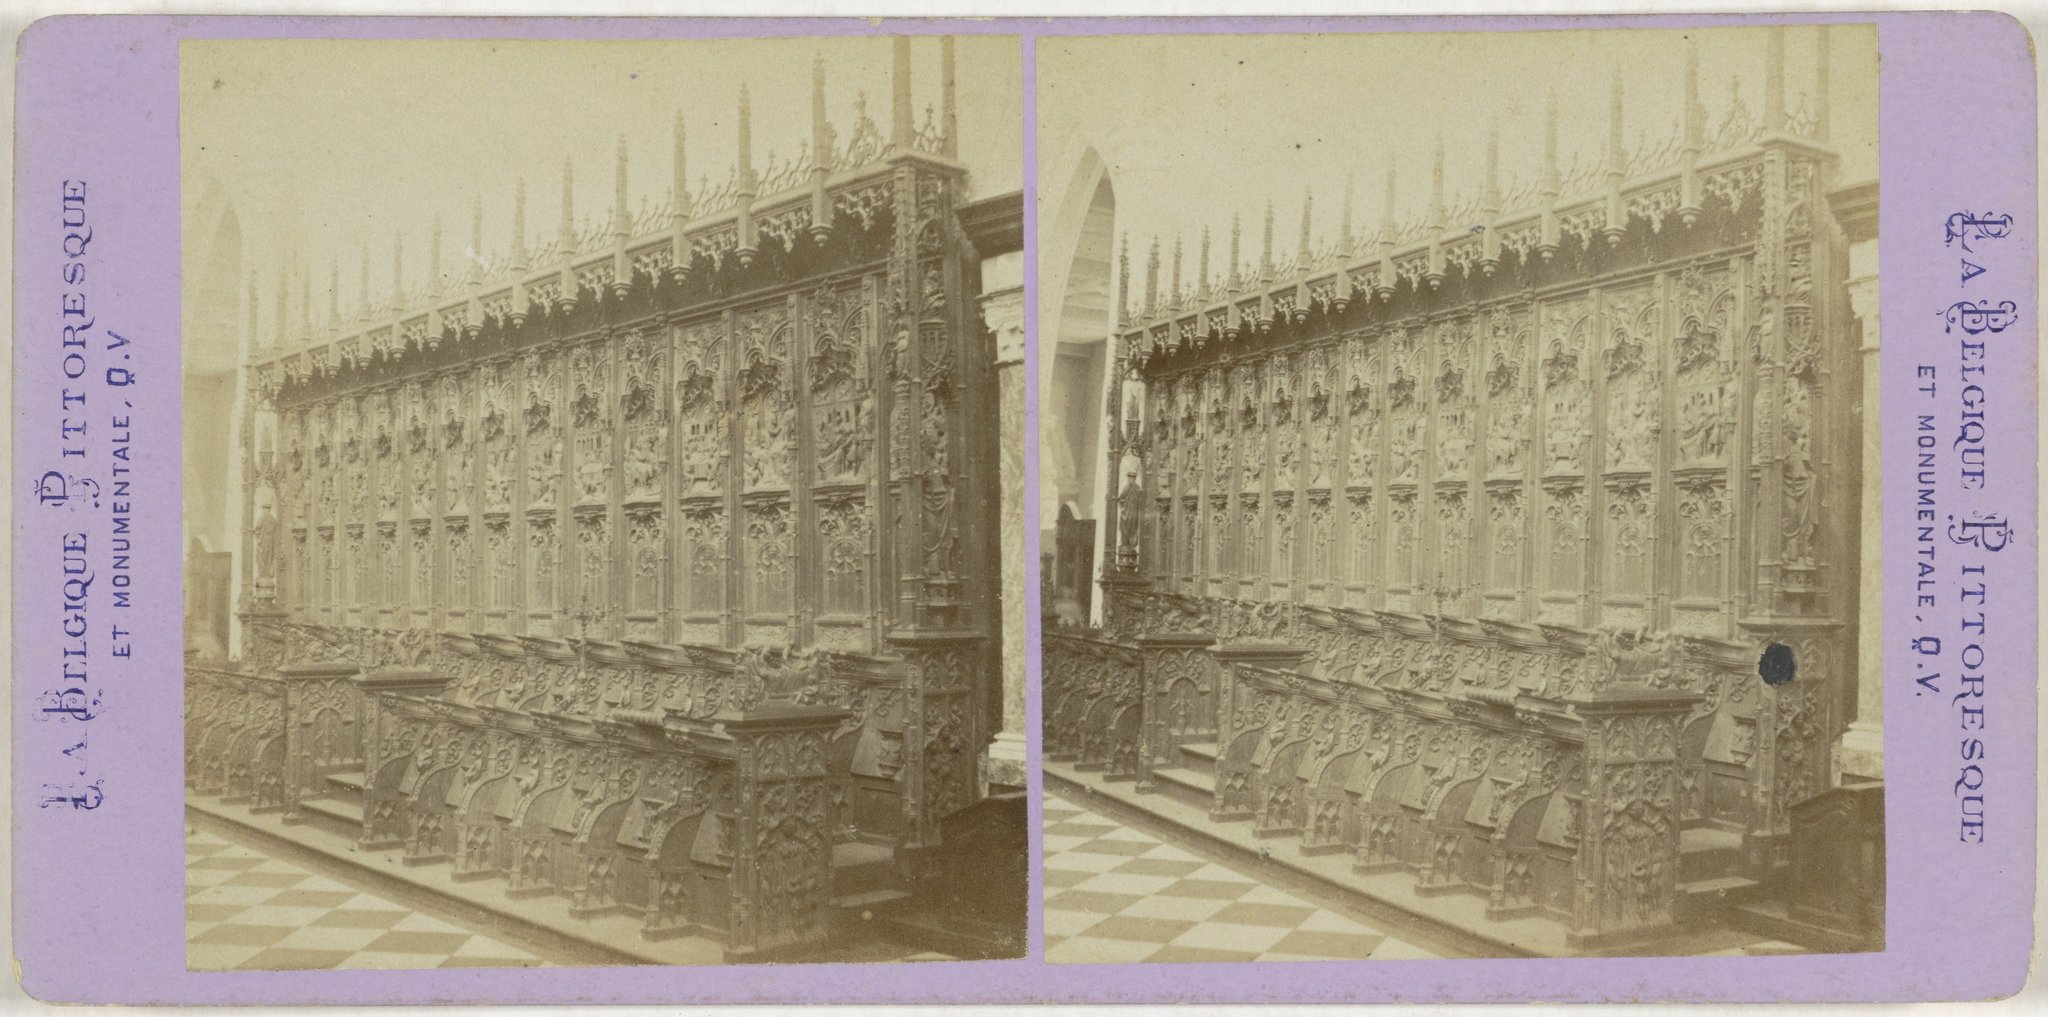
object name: stereograph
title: Koor van de Sint-Geertruikerk in Leuven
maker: jules hippolyte quéval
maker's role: publisher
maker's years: 1824-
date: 1866-1870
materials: cardboard, paper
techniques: albumen print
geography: leuven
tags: parts of church interior: choir, louvain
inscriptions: number: ‘No 1727’